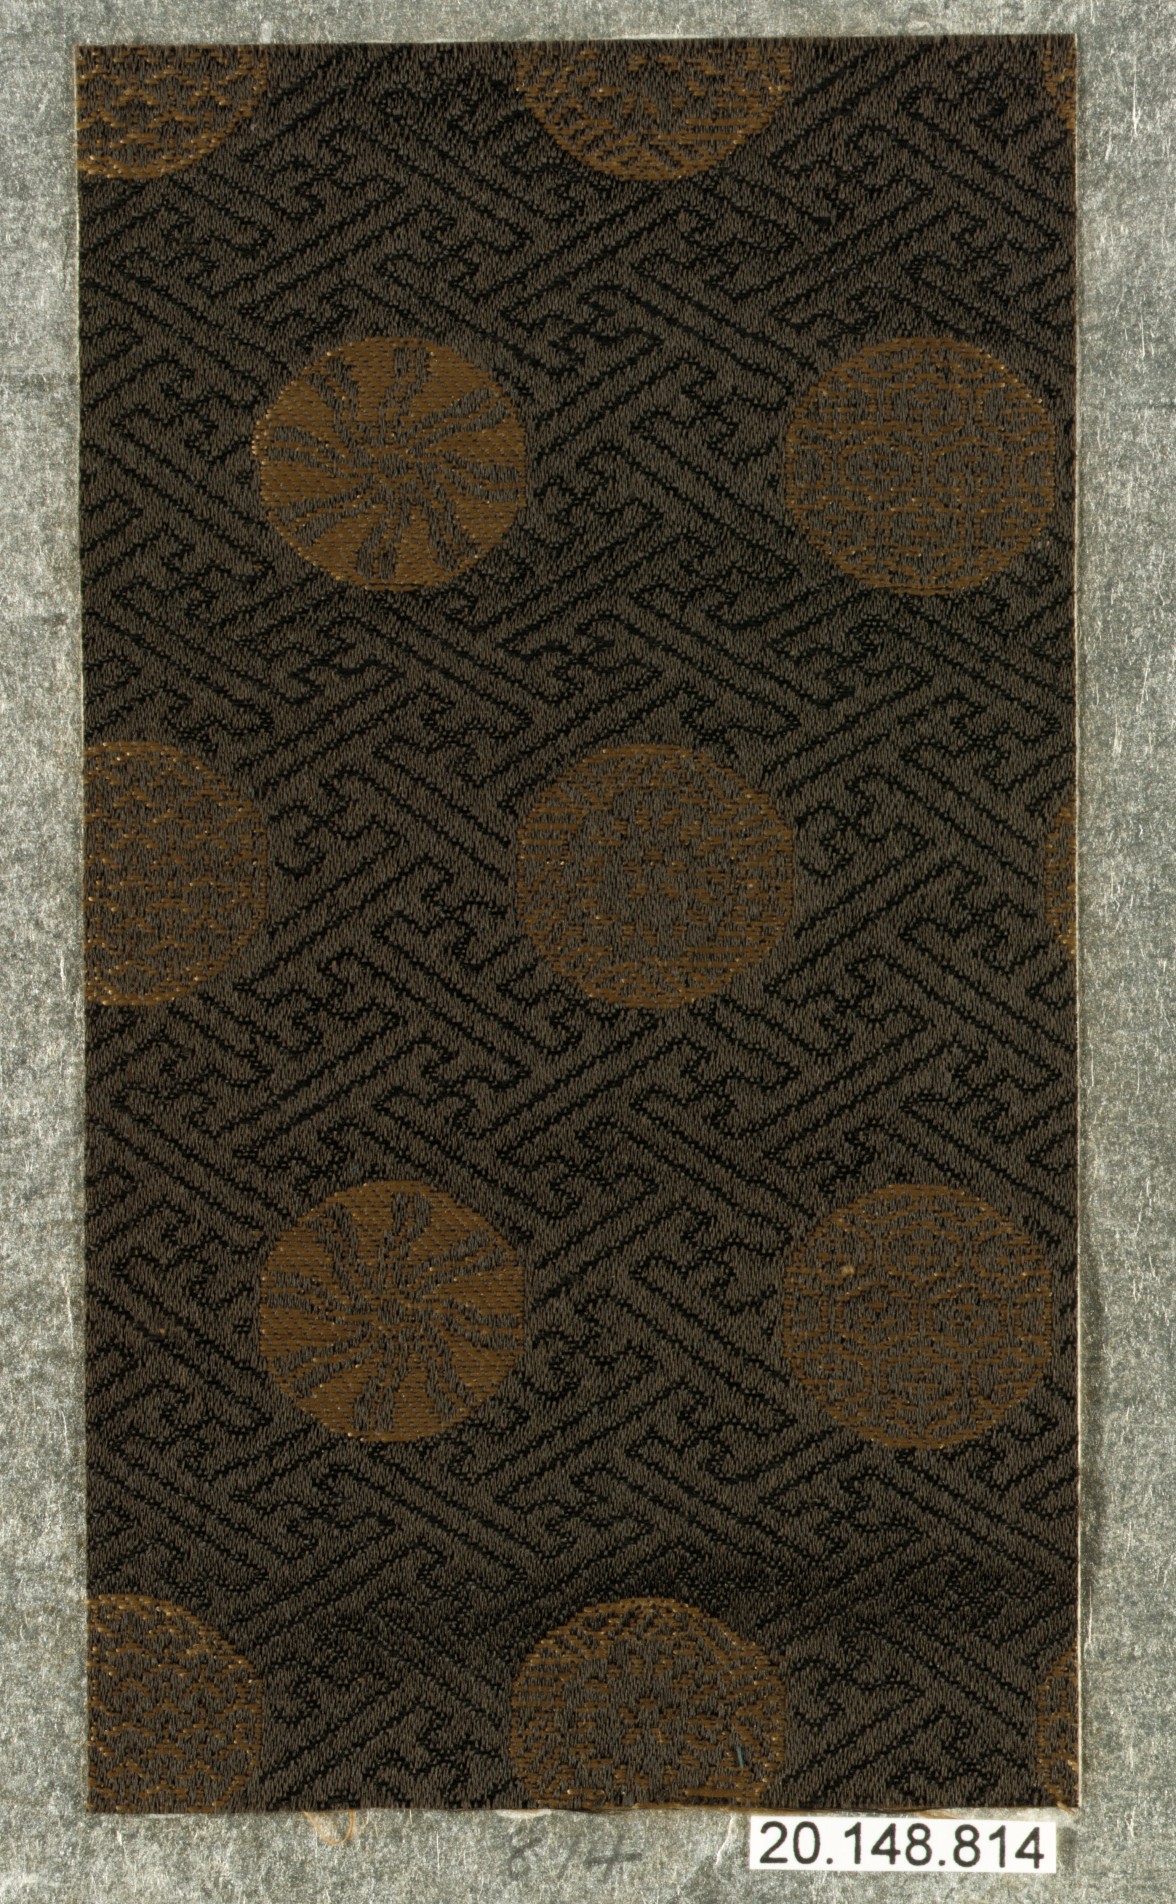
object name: piece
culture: japanese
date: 1701-1800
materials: silk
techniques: compound weave